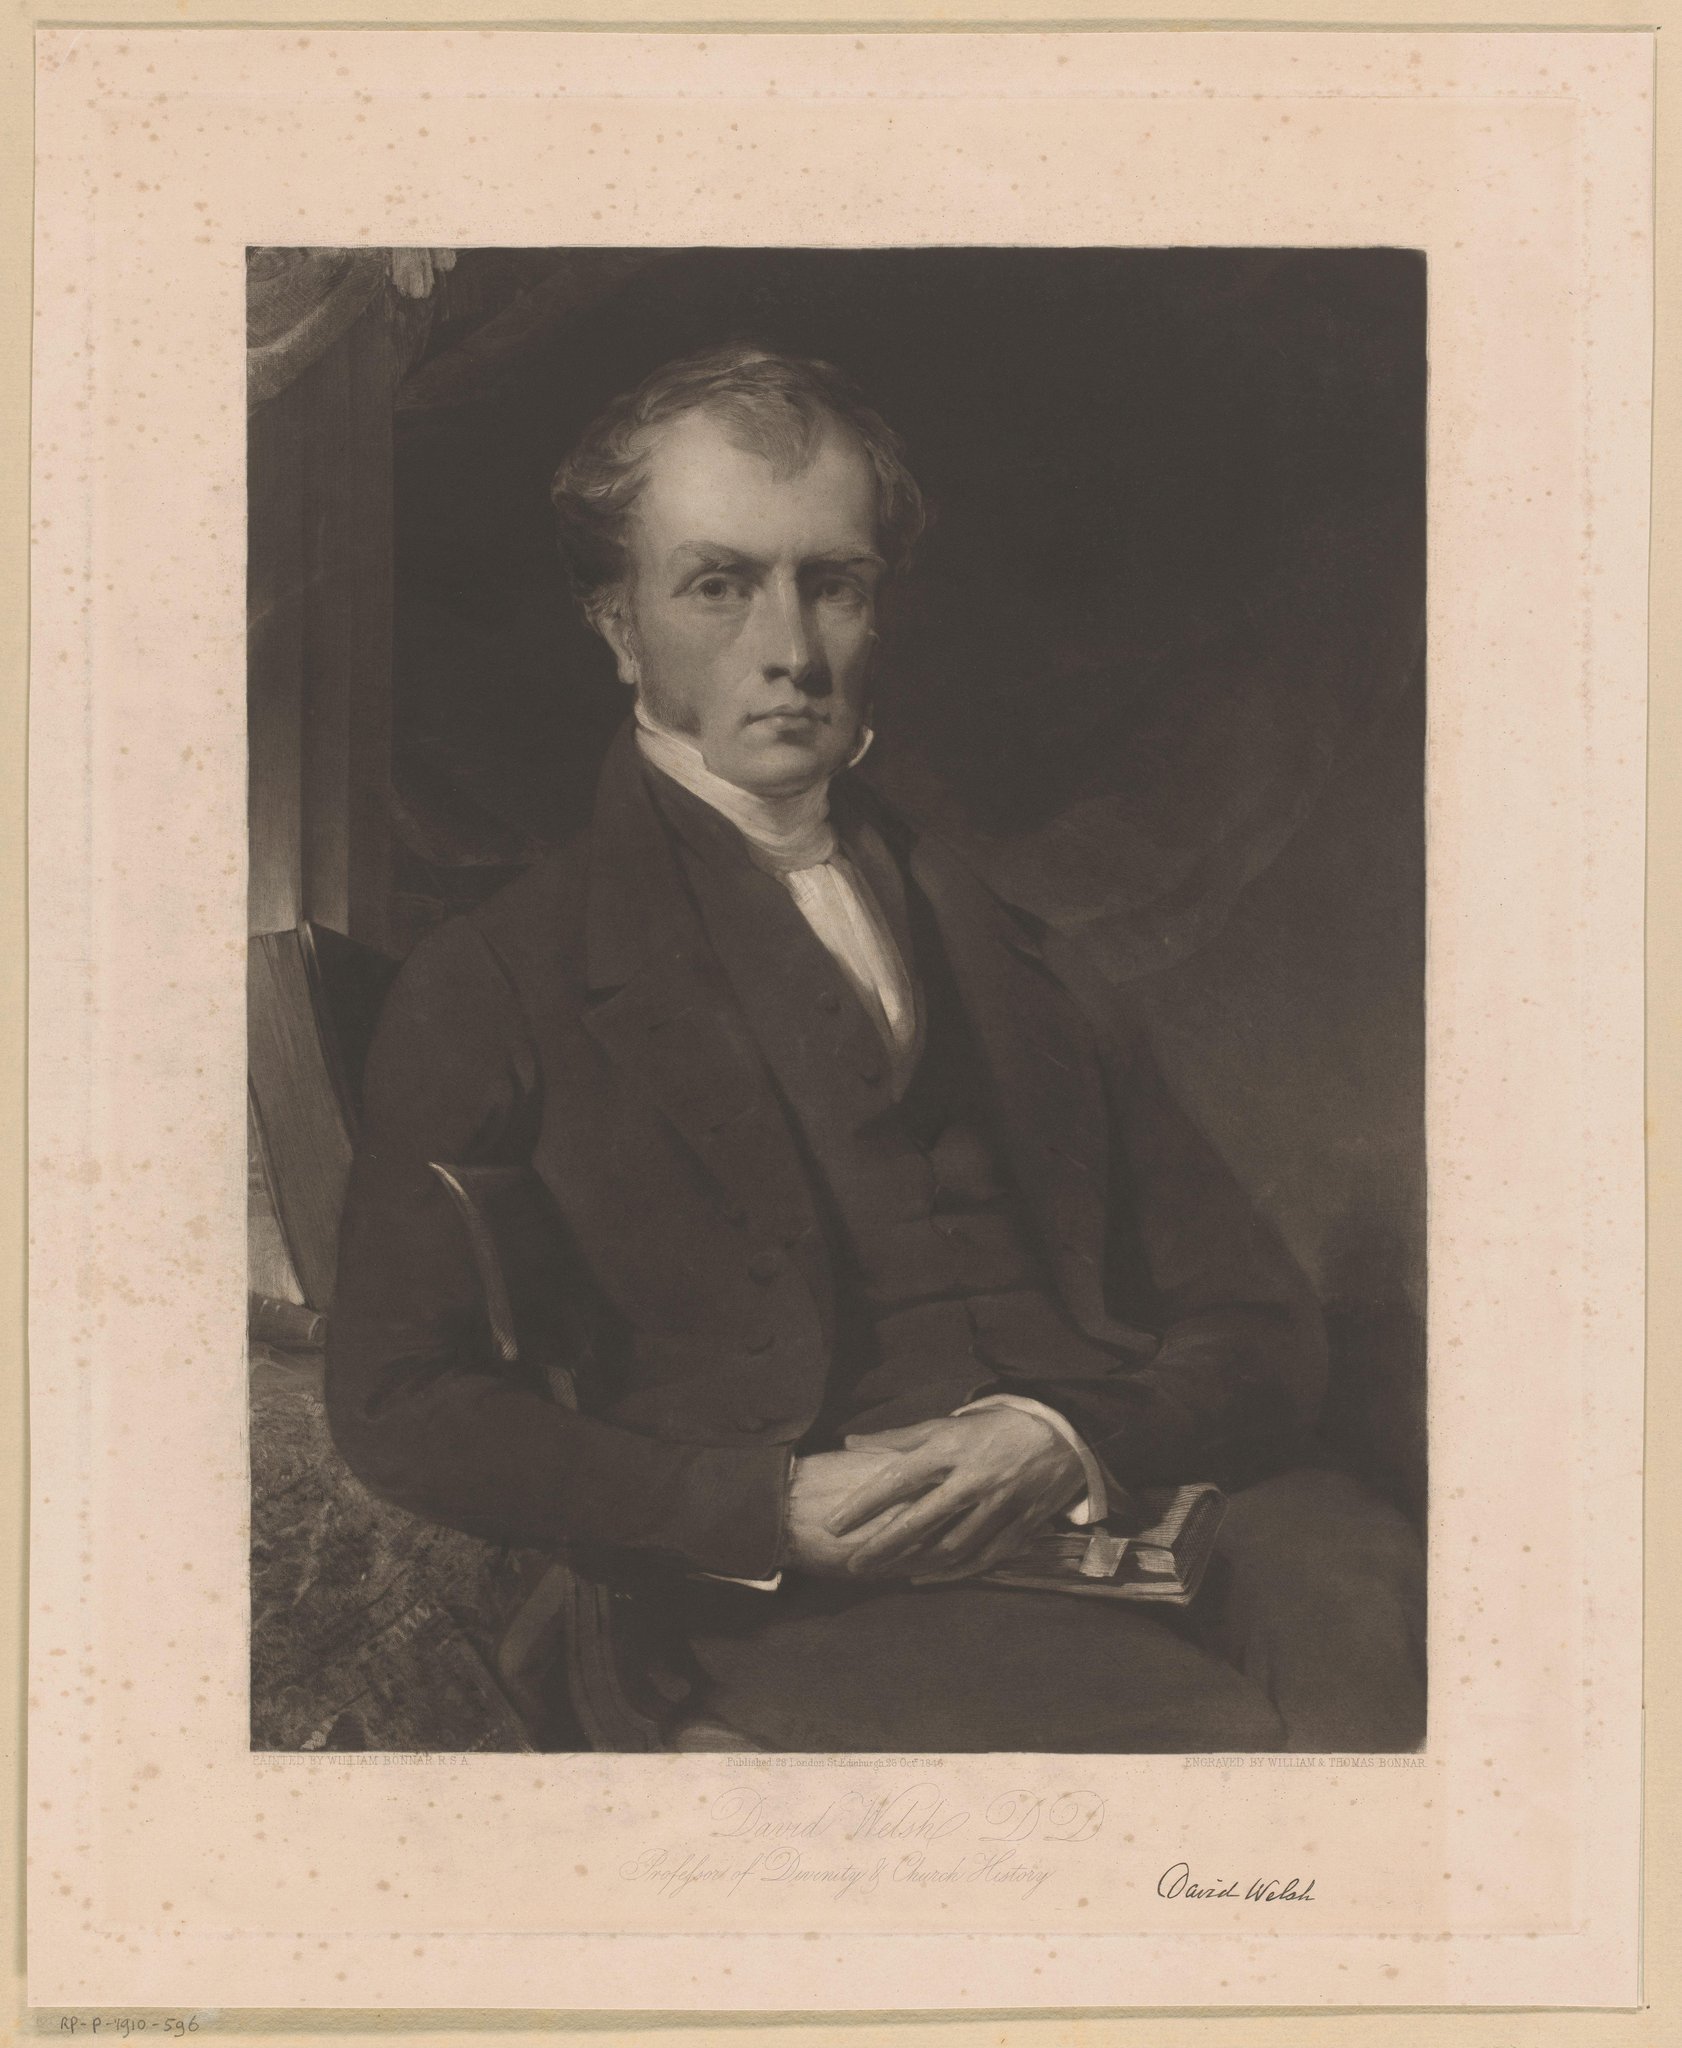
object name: print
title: Portret van David Welsh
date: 1810-1846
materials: paper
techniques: mezzotint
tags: historical persons, professor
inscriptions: collector's mark: Lugt 2228